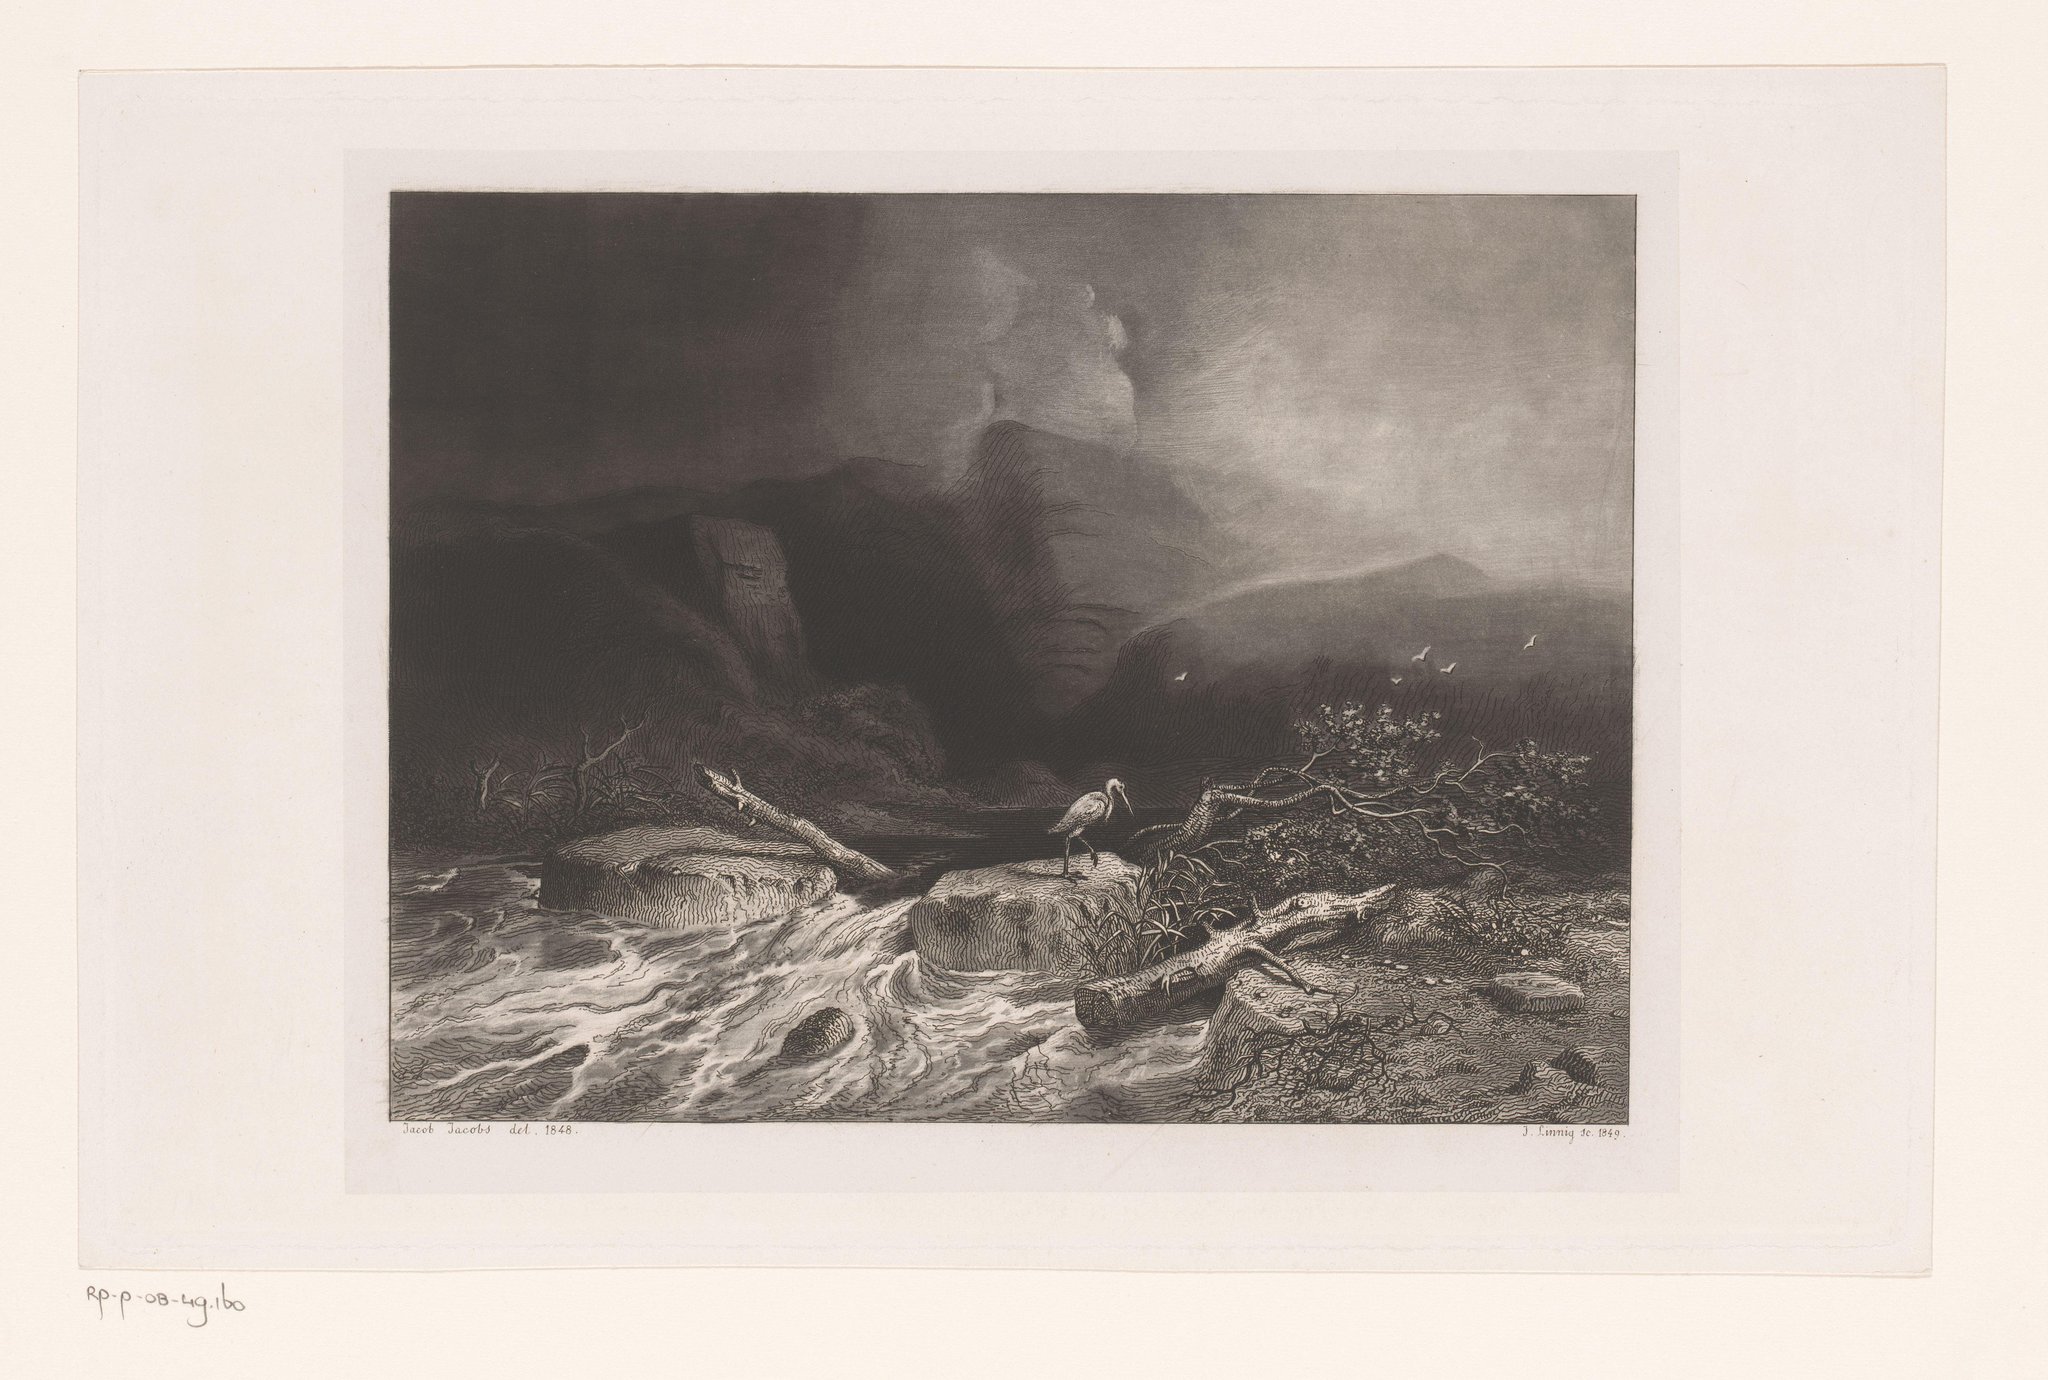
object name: print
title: Rotsachtig landschap met rivier en reiger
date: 1849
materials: paper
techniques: etching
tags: river, shore-birds and wading-birds: heron, boulder, stone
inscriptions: date